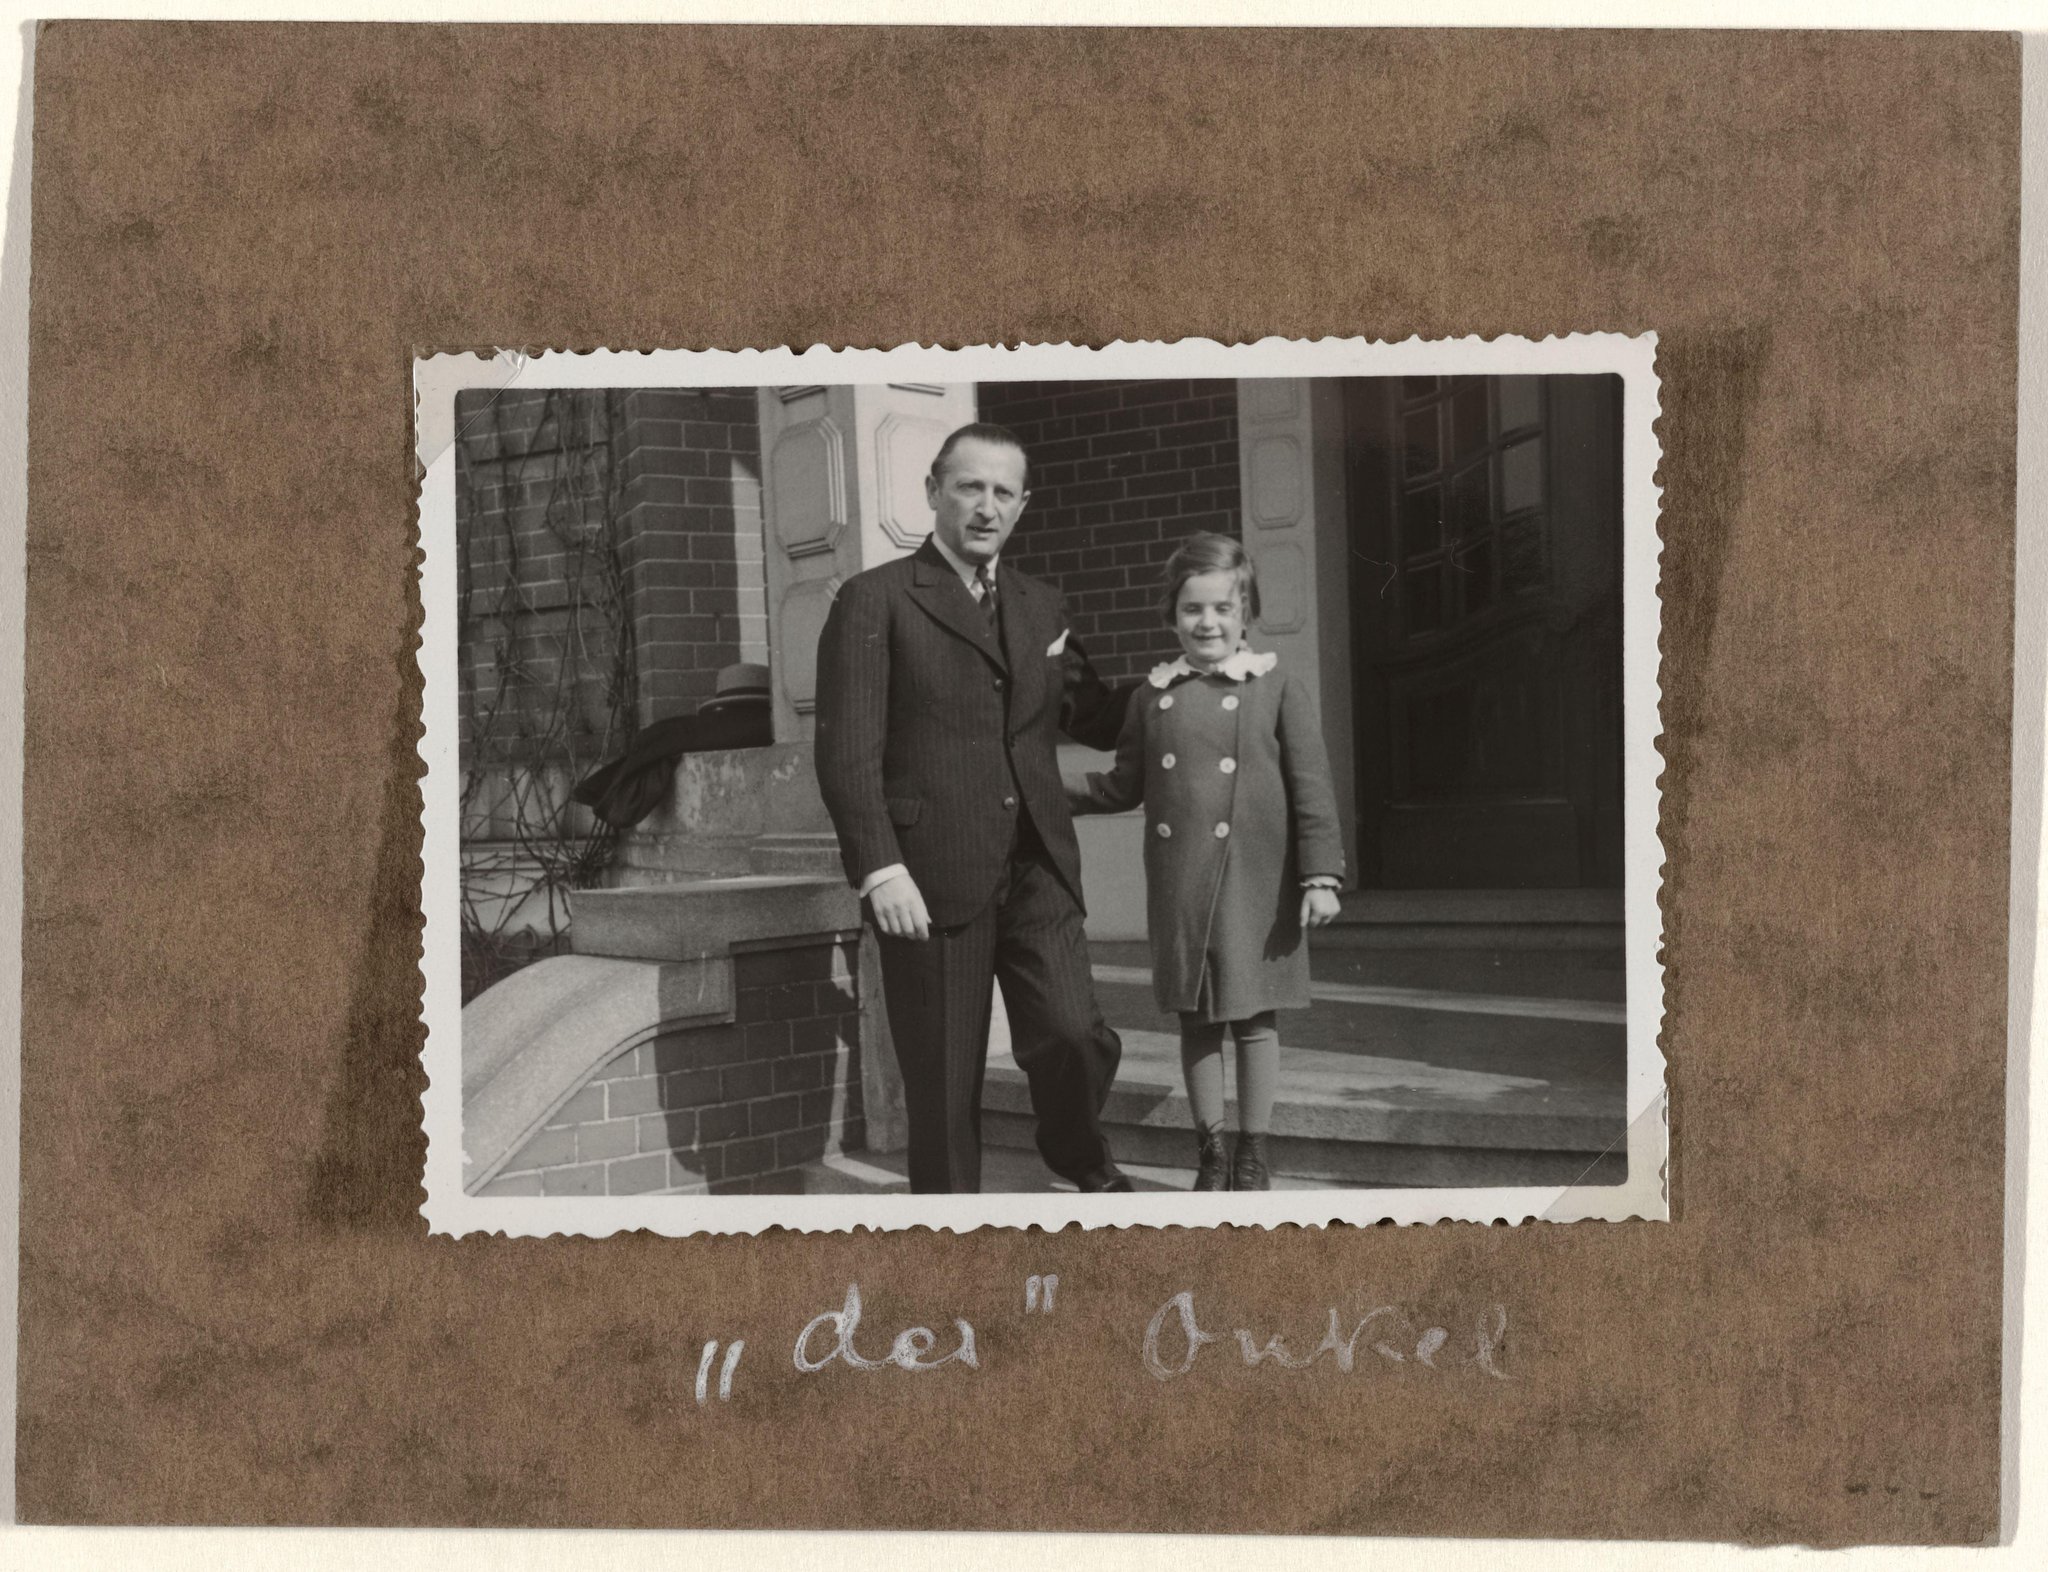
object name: photograph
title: Isabel Wachenheimer en haar oom Willy Moos voor diens huis in Hamburg Bellevue 62, in september 1934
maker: Anonymous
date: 1909-1934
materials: photographic support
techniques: gelatin silver print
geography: hamburg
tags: isabel wachenheimer-elon, willy moos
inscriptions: name: ‘,,der'' Onkel’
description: Dit object is onderdeel van de nalatenschap van Isabel Elon-Wachenheimer (1928-2010). Tot haar overlijden behoorde het samen met de andere objecten uit de nalatenschap tot haar privédomein van Isabel Wachenheimer. In die particuliere context zijn deze objecten tezamen en individueel aandenkens - aan de jeugd, ouders en familie van Isabel Wachenheimer vóór en tijdens de Shoah en aan haar leven na de Tweede Wereldoorlog. Isabel Wachenheimer, die van juni 1943 tot mei 1945 gevangen zat in Kamp Westerbork, Theresienstadt, Auschwitz, Lenzing a/d Oberdonau (een buitenkamp van Mauthausen), overleefde de Shoah. Haar ouders – Eugène Wachenheimer en Else Wachenheimer-Moos - werden op 14 oktober 1944 in Auschwitz-Birkenau vermoord.